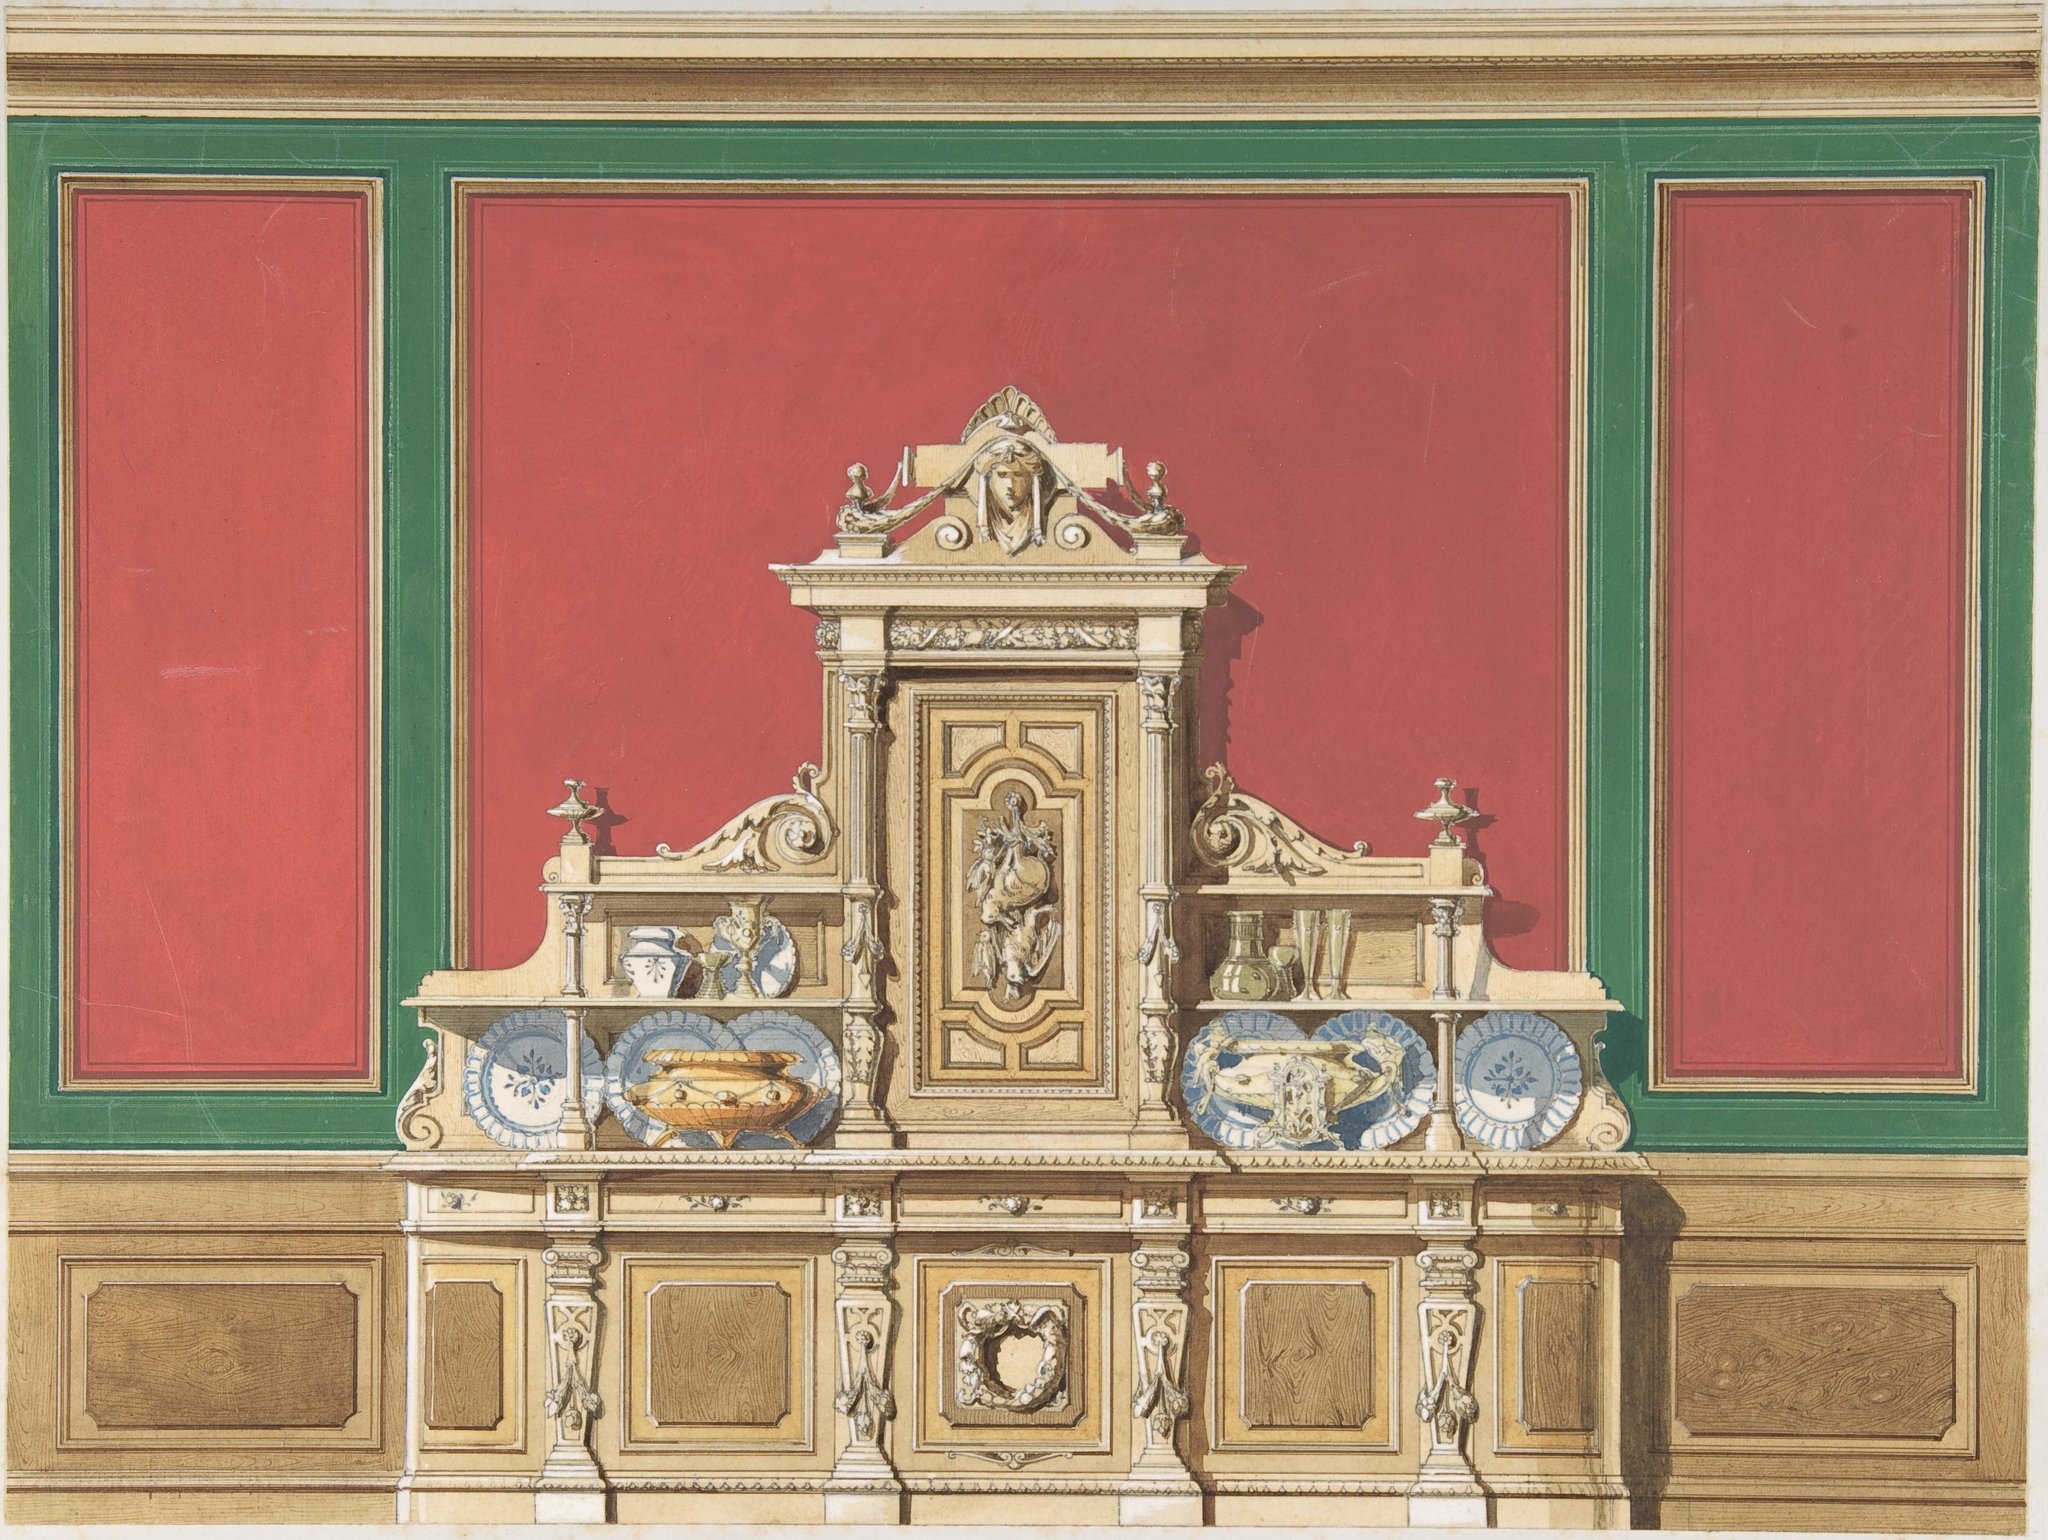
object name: drawing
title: Interior Design for Large Display Cabinet against Red and Green Panelling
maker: anonymous, british, 19th century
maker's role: artist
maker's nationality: british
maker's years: 1800-1900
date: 1867-1900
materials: gouache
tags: interiors,cabinets